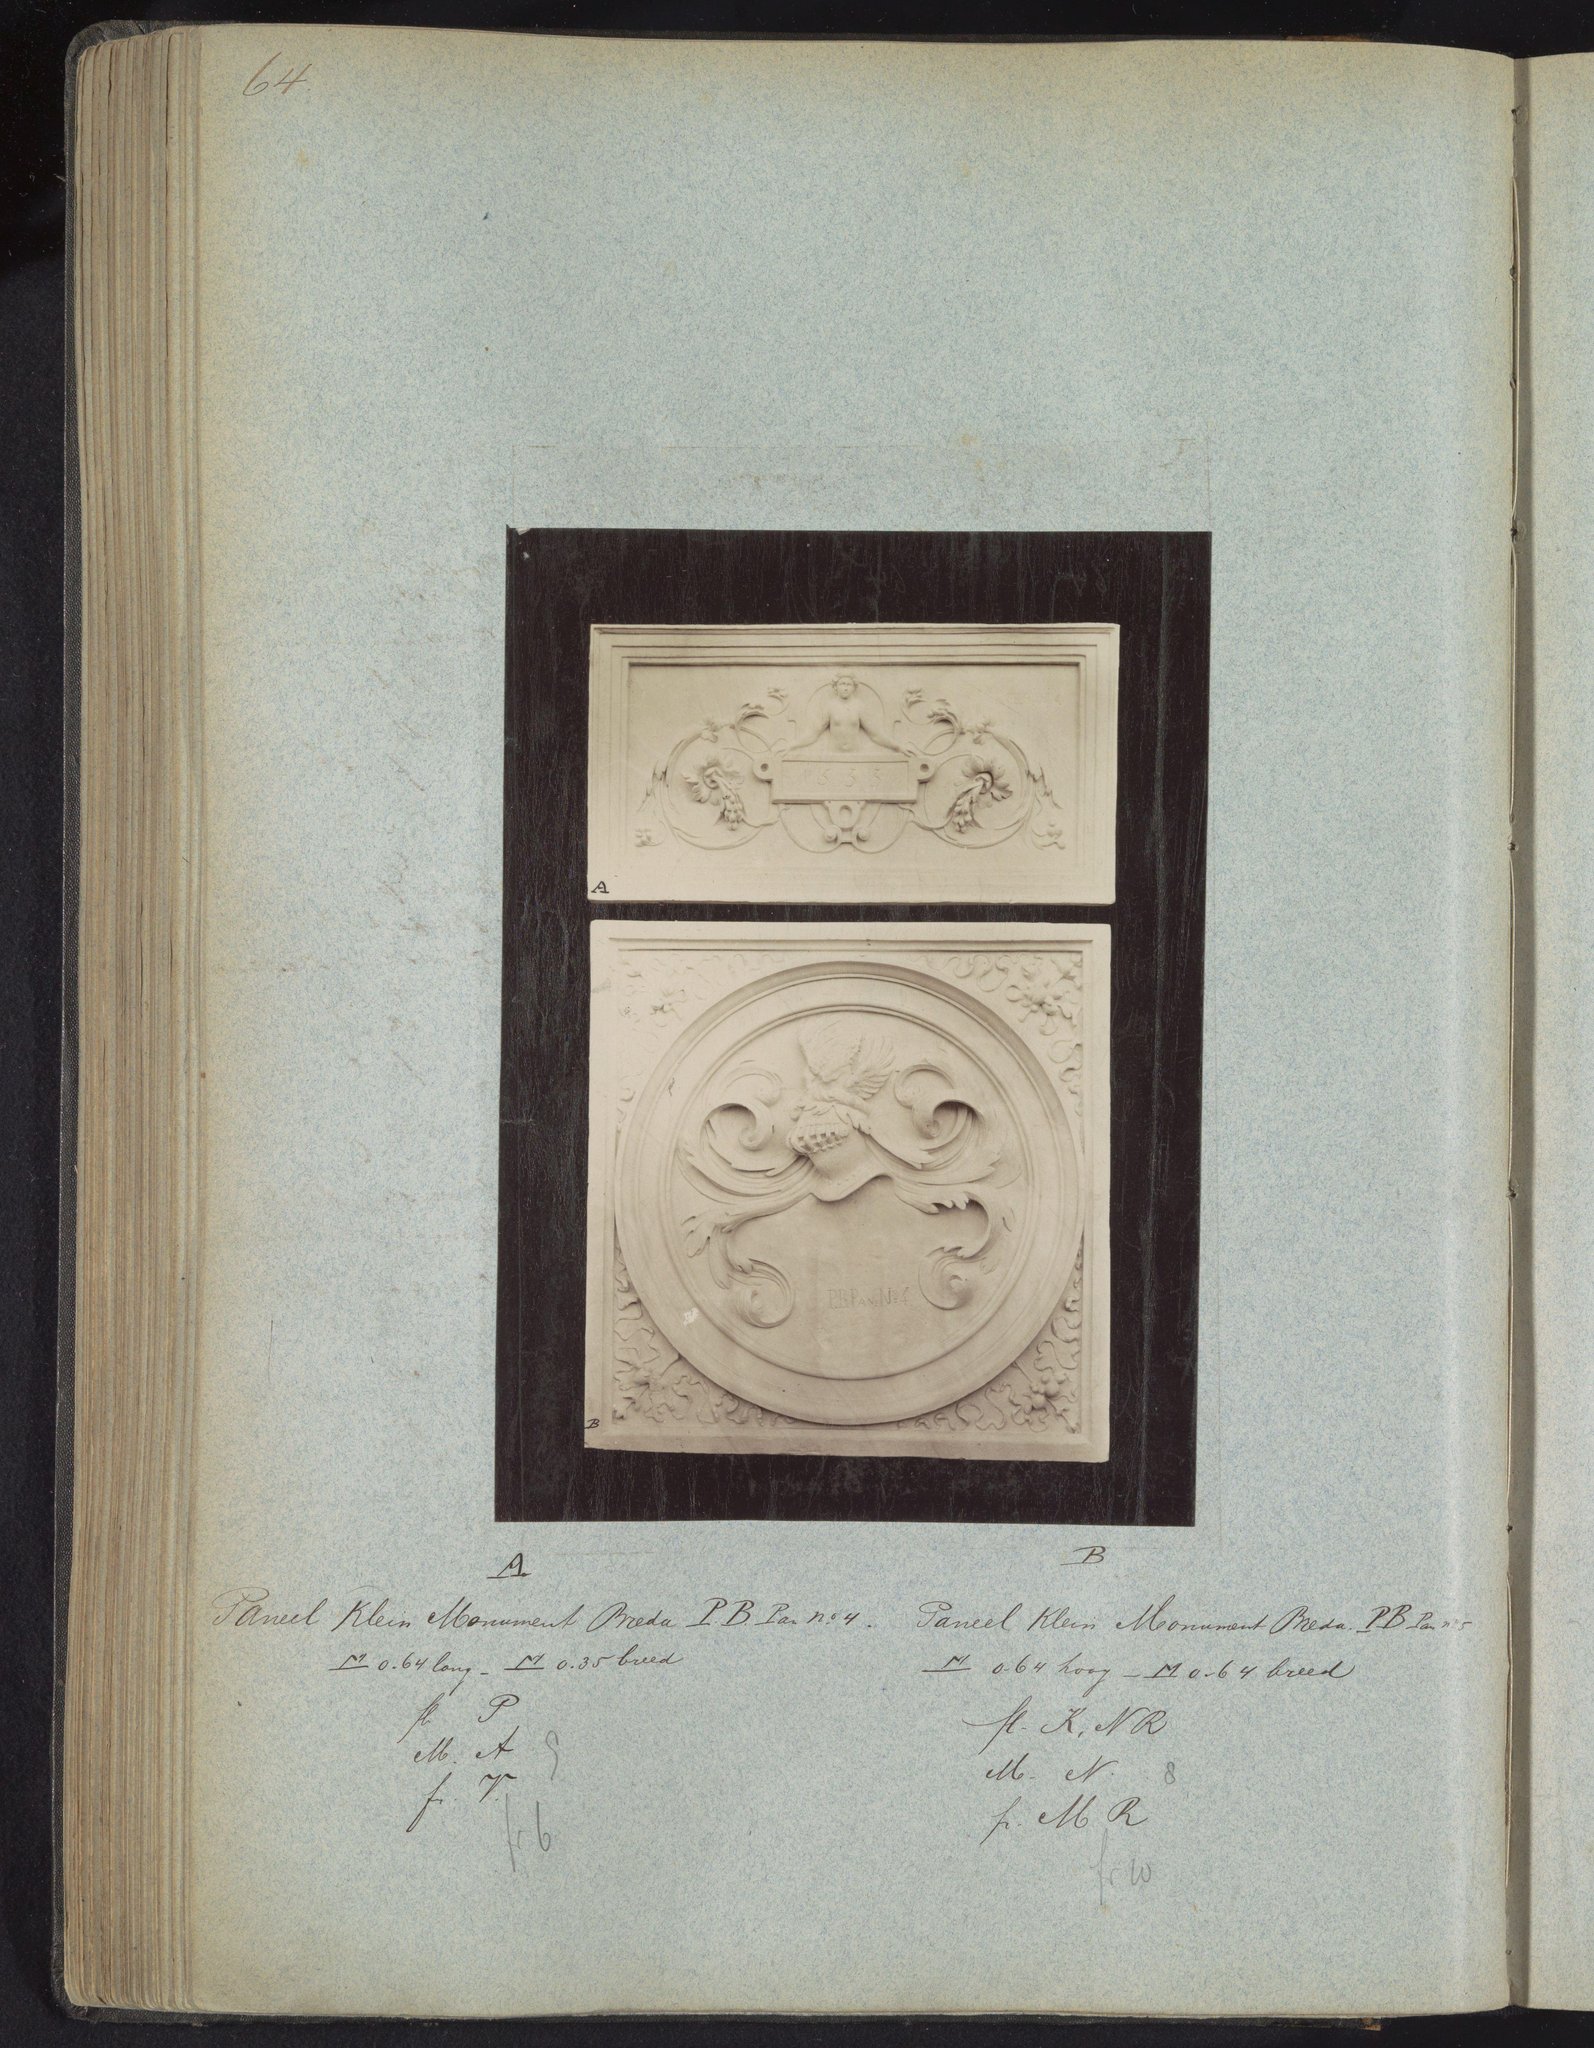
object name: photograph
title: Twee gipsen afgietsels van panelen van een monument te Breda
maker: Anonymous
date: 1875-1900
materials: paper, photographic support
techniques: albumen print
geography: breda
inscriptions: annotation, annotation: ‘A / Paneel Klein Monument Breda / M 0.64 lang - M 0.35 breed’, annotation: ‘B / Paneel Klein Monument Breda / M 0. 64 hoog - M 0.64 breed’